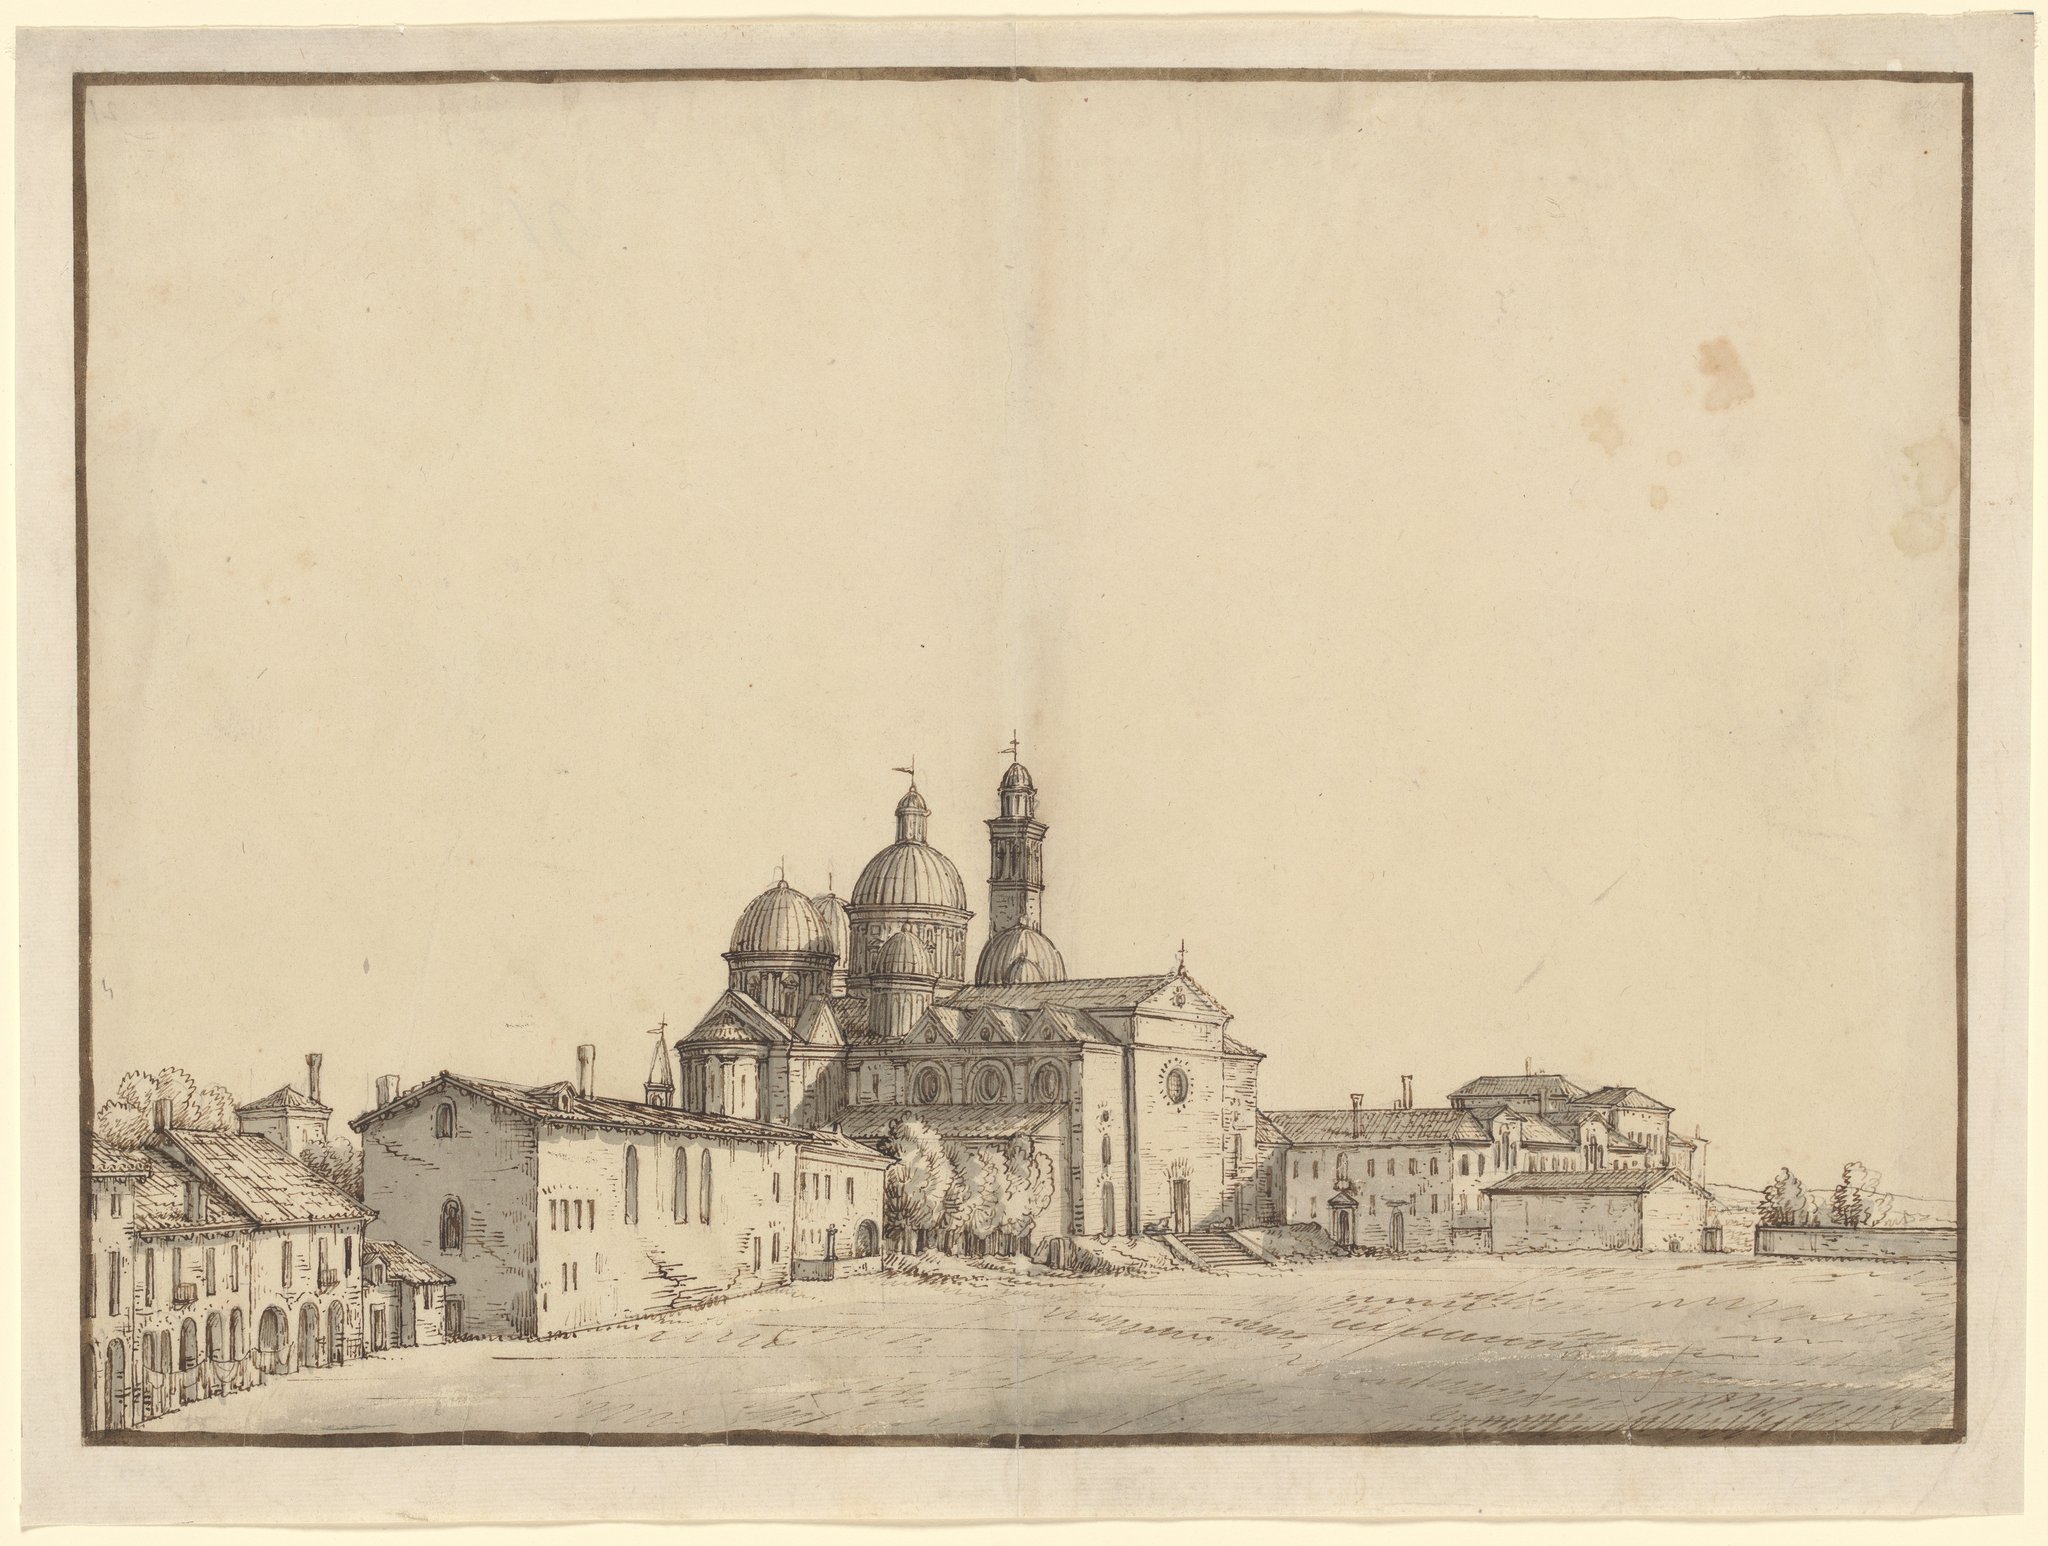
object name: drawing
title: Santa Giustina and the Prato della Valle at Padua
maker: bernardo bellotto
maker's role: artist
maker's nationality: italian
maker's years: 1722-1780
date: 1740-1741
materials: ink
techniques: pen, wash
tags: buildings